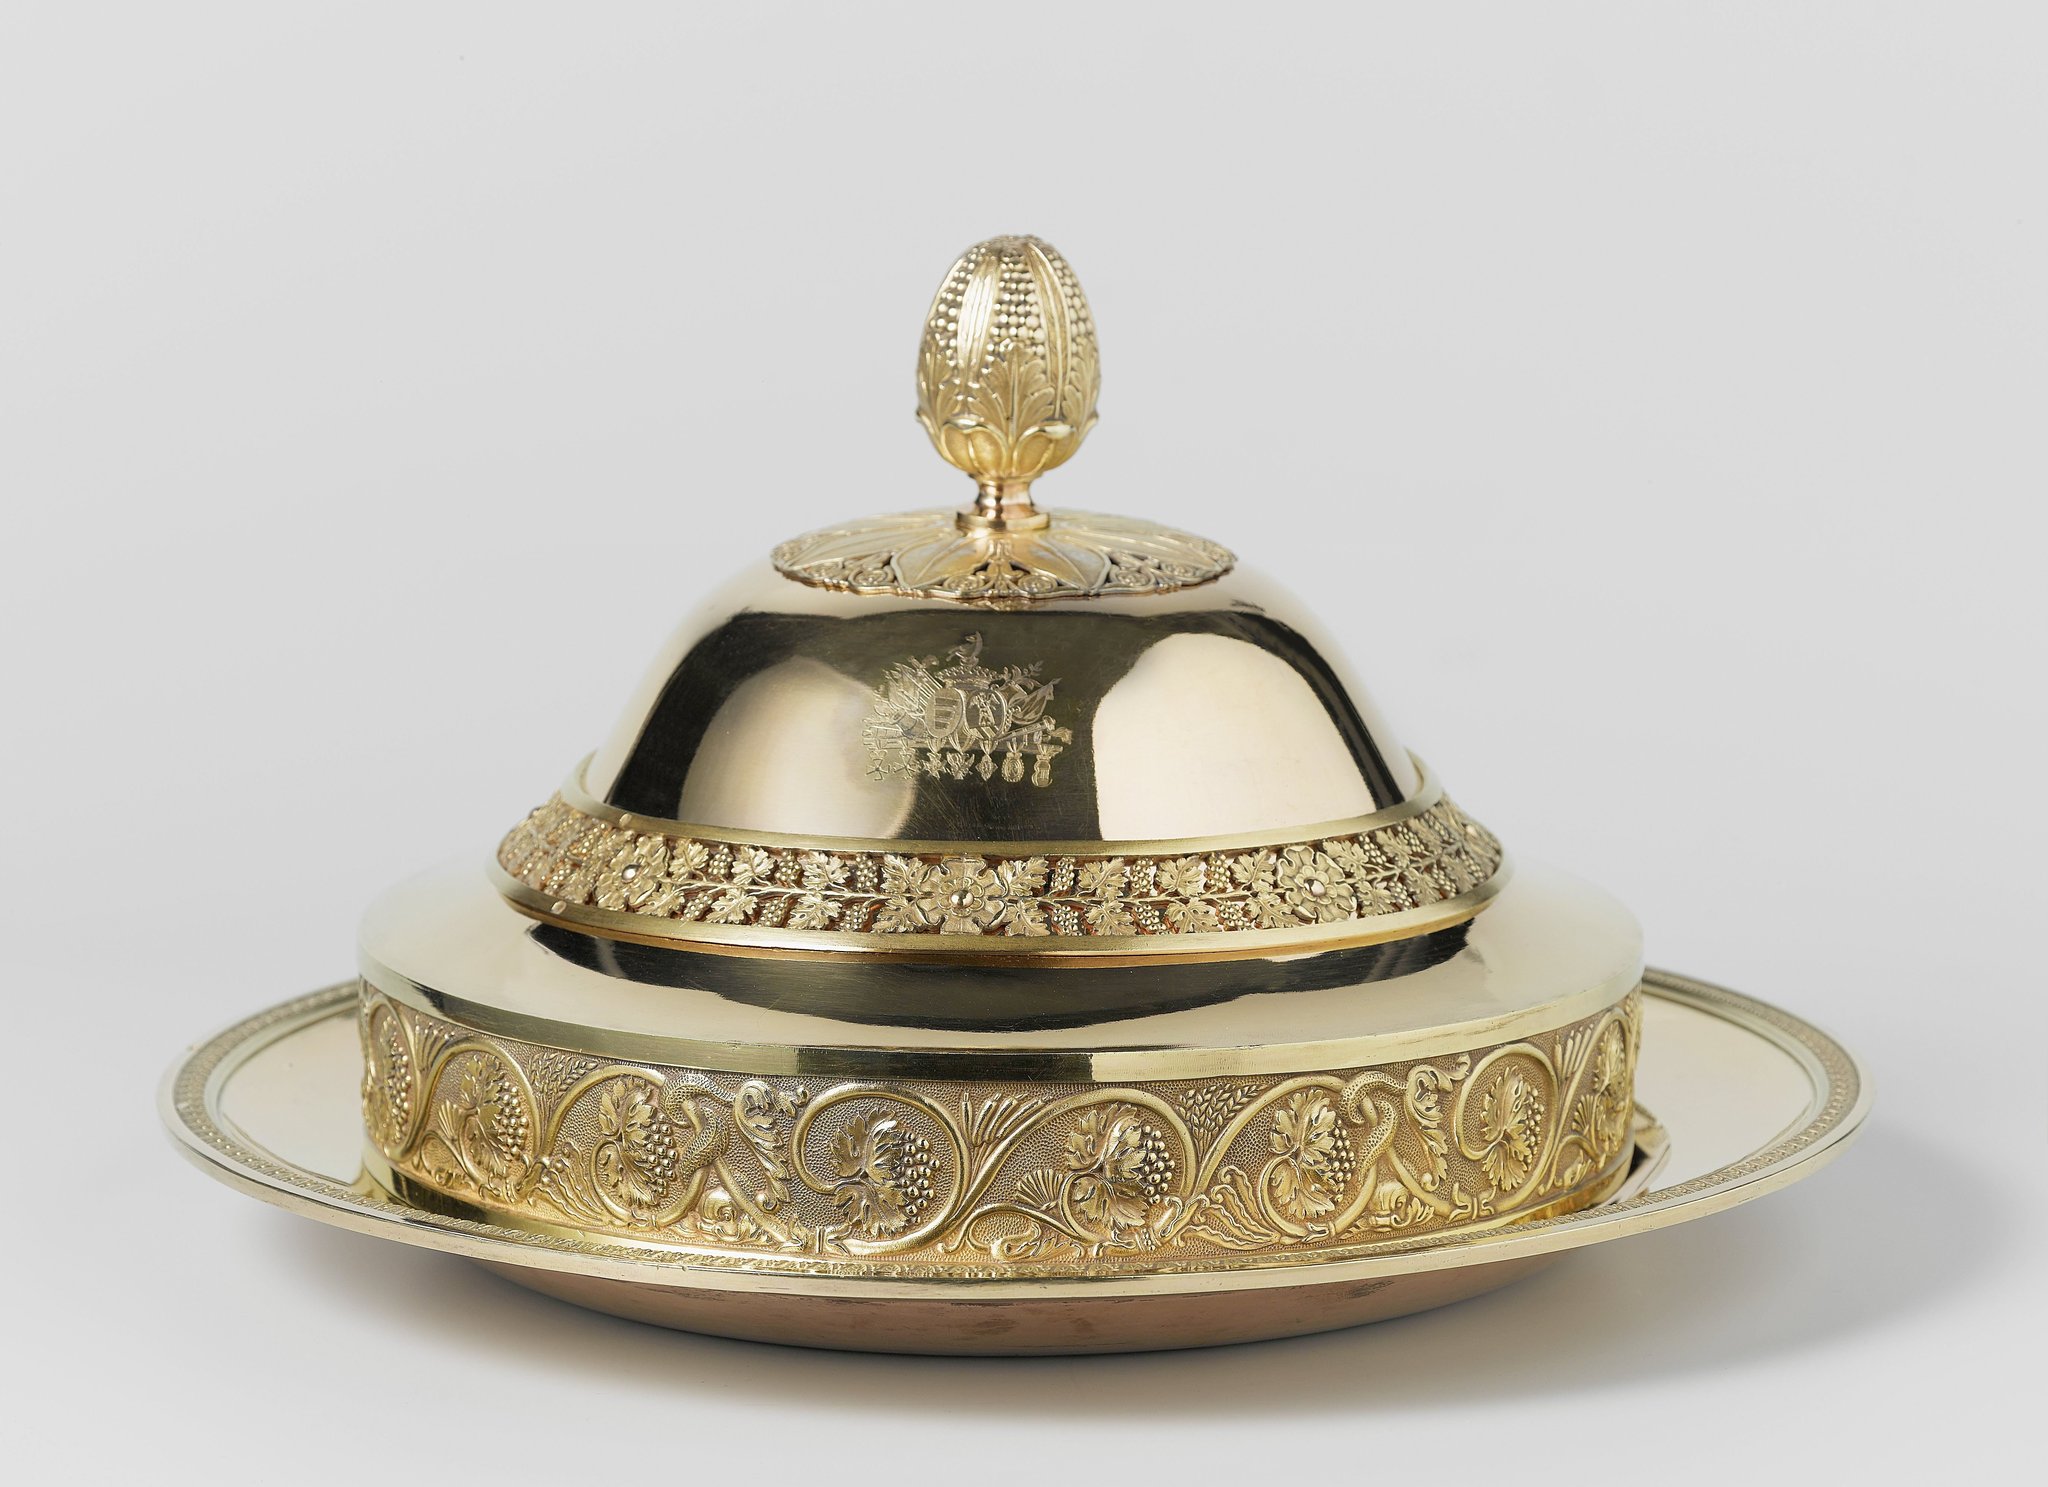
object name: platter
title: Circular dish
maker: jean baptiste claude odiot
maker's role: jeweler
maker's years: 1763-1850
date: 1819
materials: silver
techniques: gilding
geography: paris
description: Dinner service. Silver-gilt. Paris, c. 1819, by Jean Baptiste Claude Odiot. Part of an extensive dinner service made for Count Francis Xaverius Petrovich Branicki (c. 1730 - 1819) and his wife Alexandra Vassilievna Engelhardt (1754 - 1838).